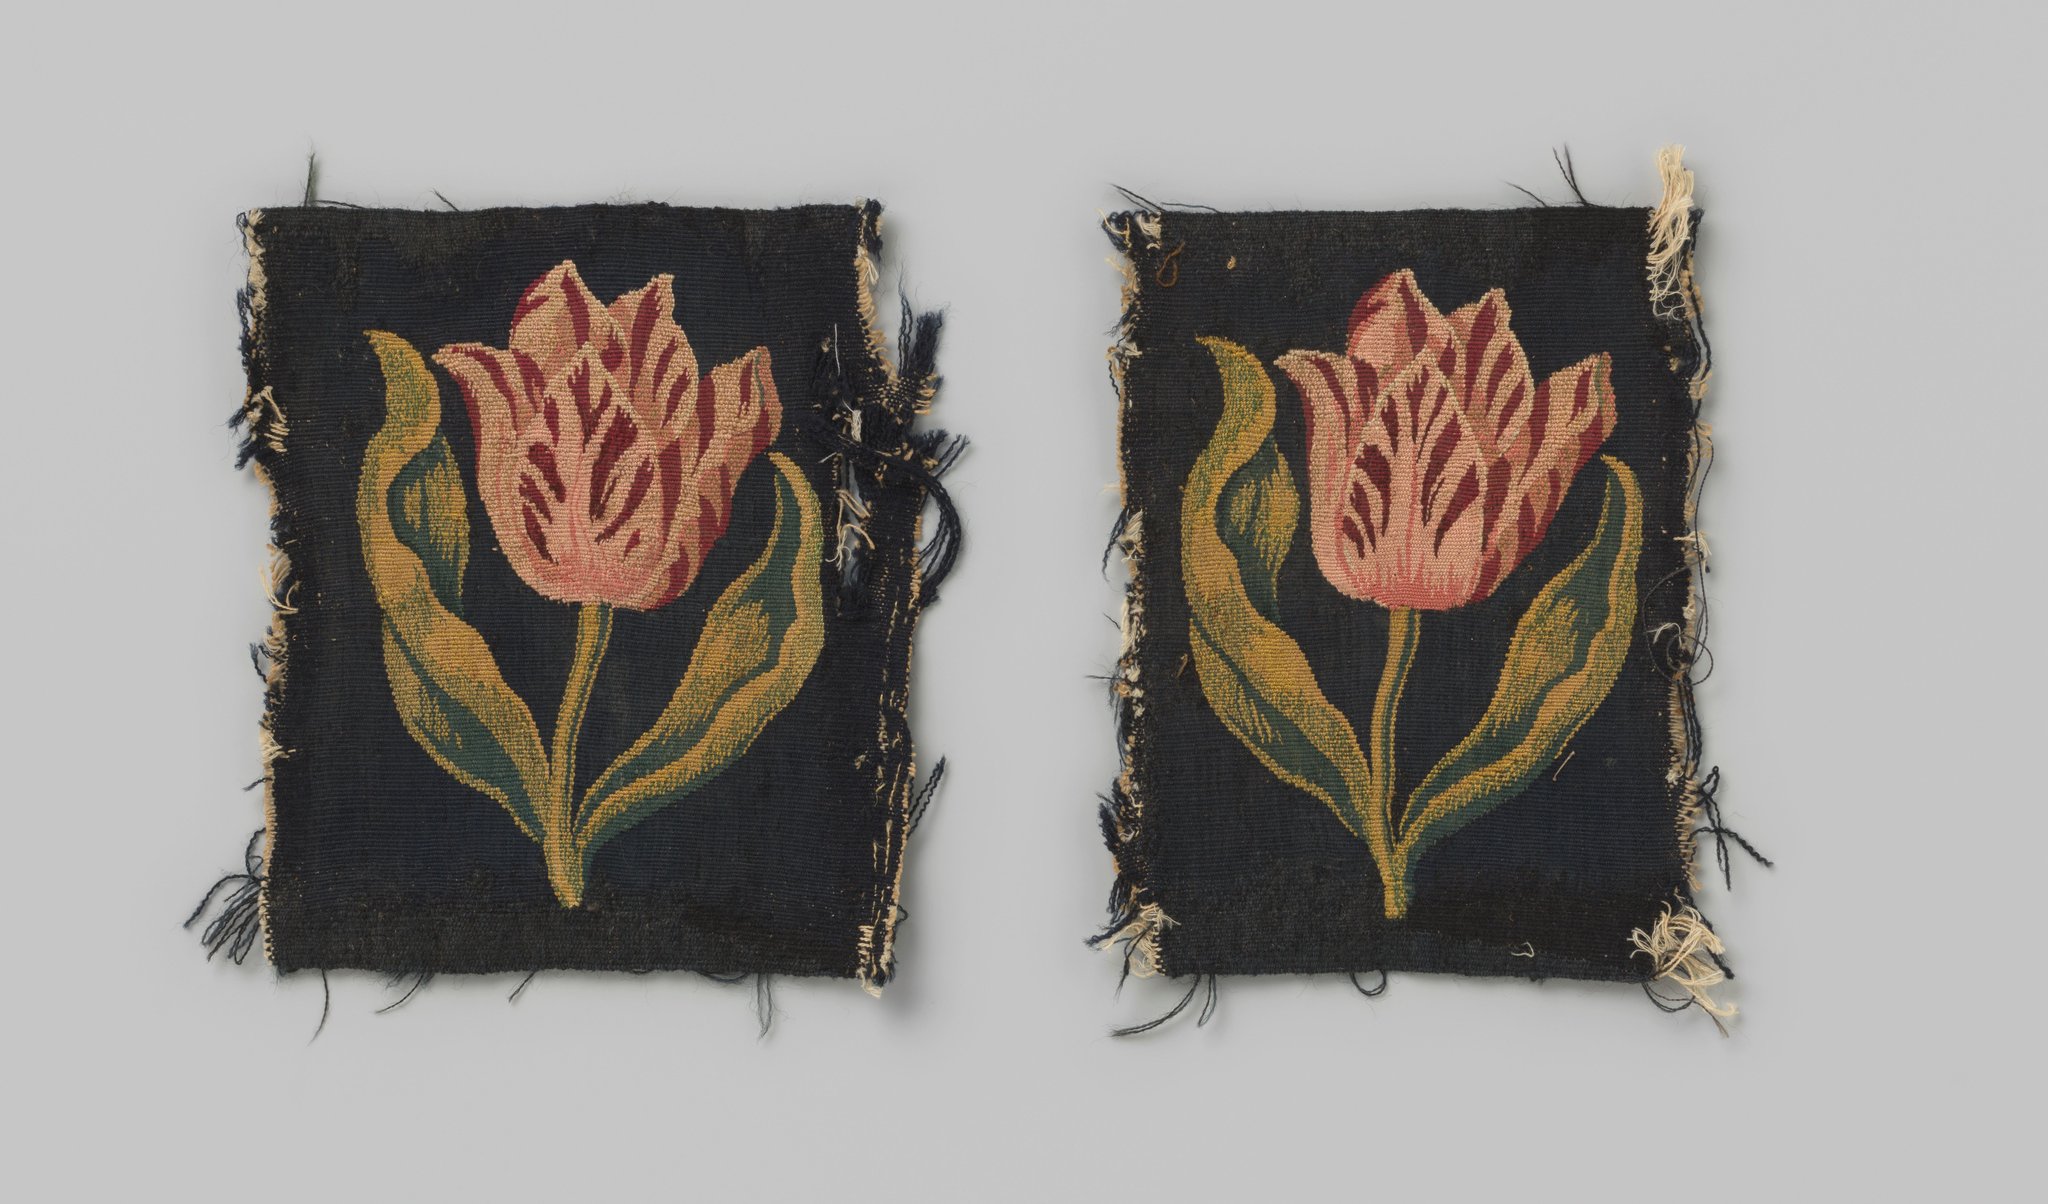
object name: stoelbekleding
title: Bekleding van stoel met geslingerde poten en geslingerd H-vormig kruis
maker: Anonymous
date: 1650-1660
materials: silk, wool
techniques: tapestry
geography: northern netherlands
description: Twee fragmenten van tapijtwerk, oorspronkelijke onderdelen van de stoelbekleding. Op een donkerblauw font is op elk fragment één tulp aangebracht op een stengel met twee bladeren. De tulpen zijn roze, met wit en donkerrood.